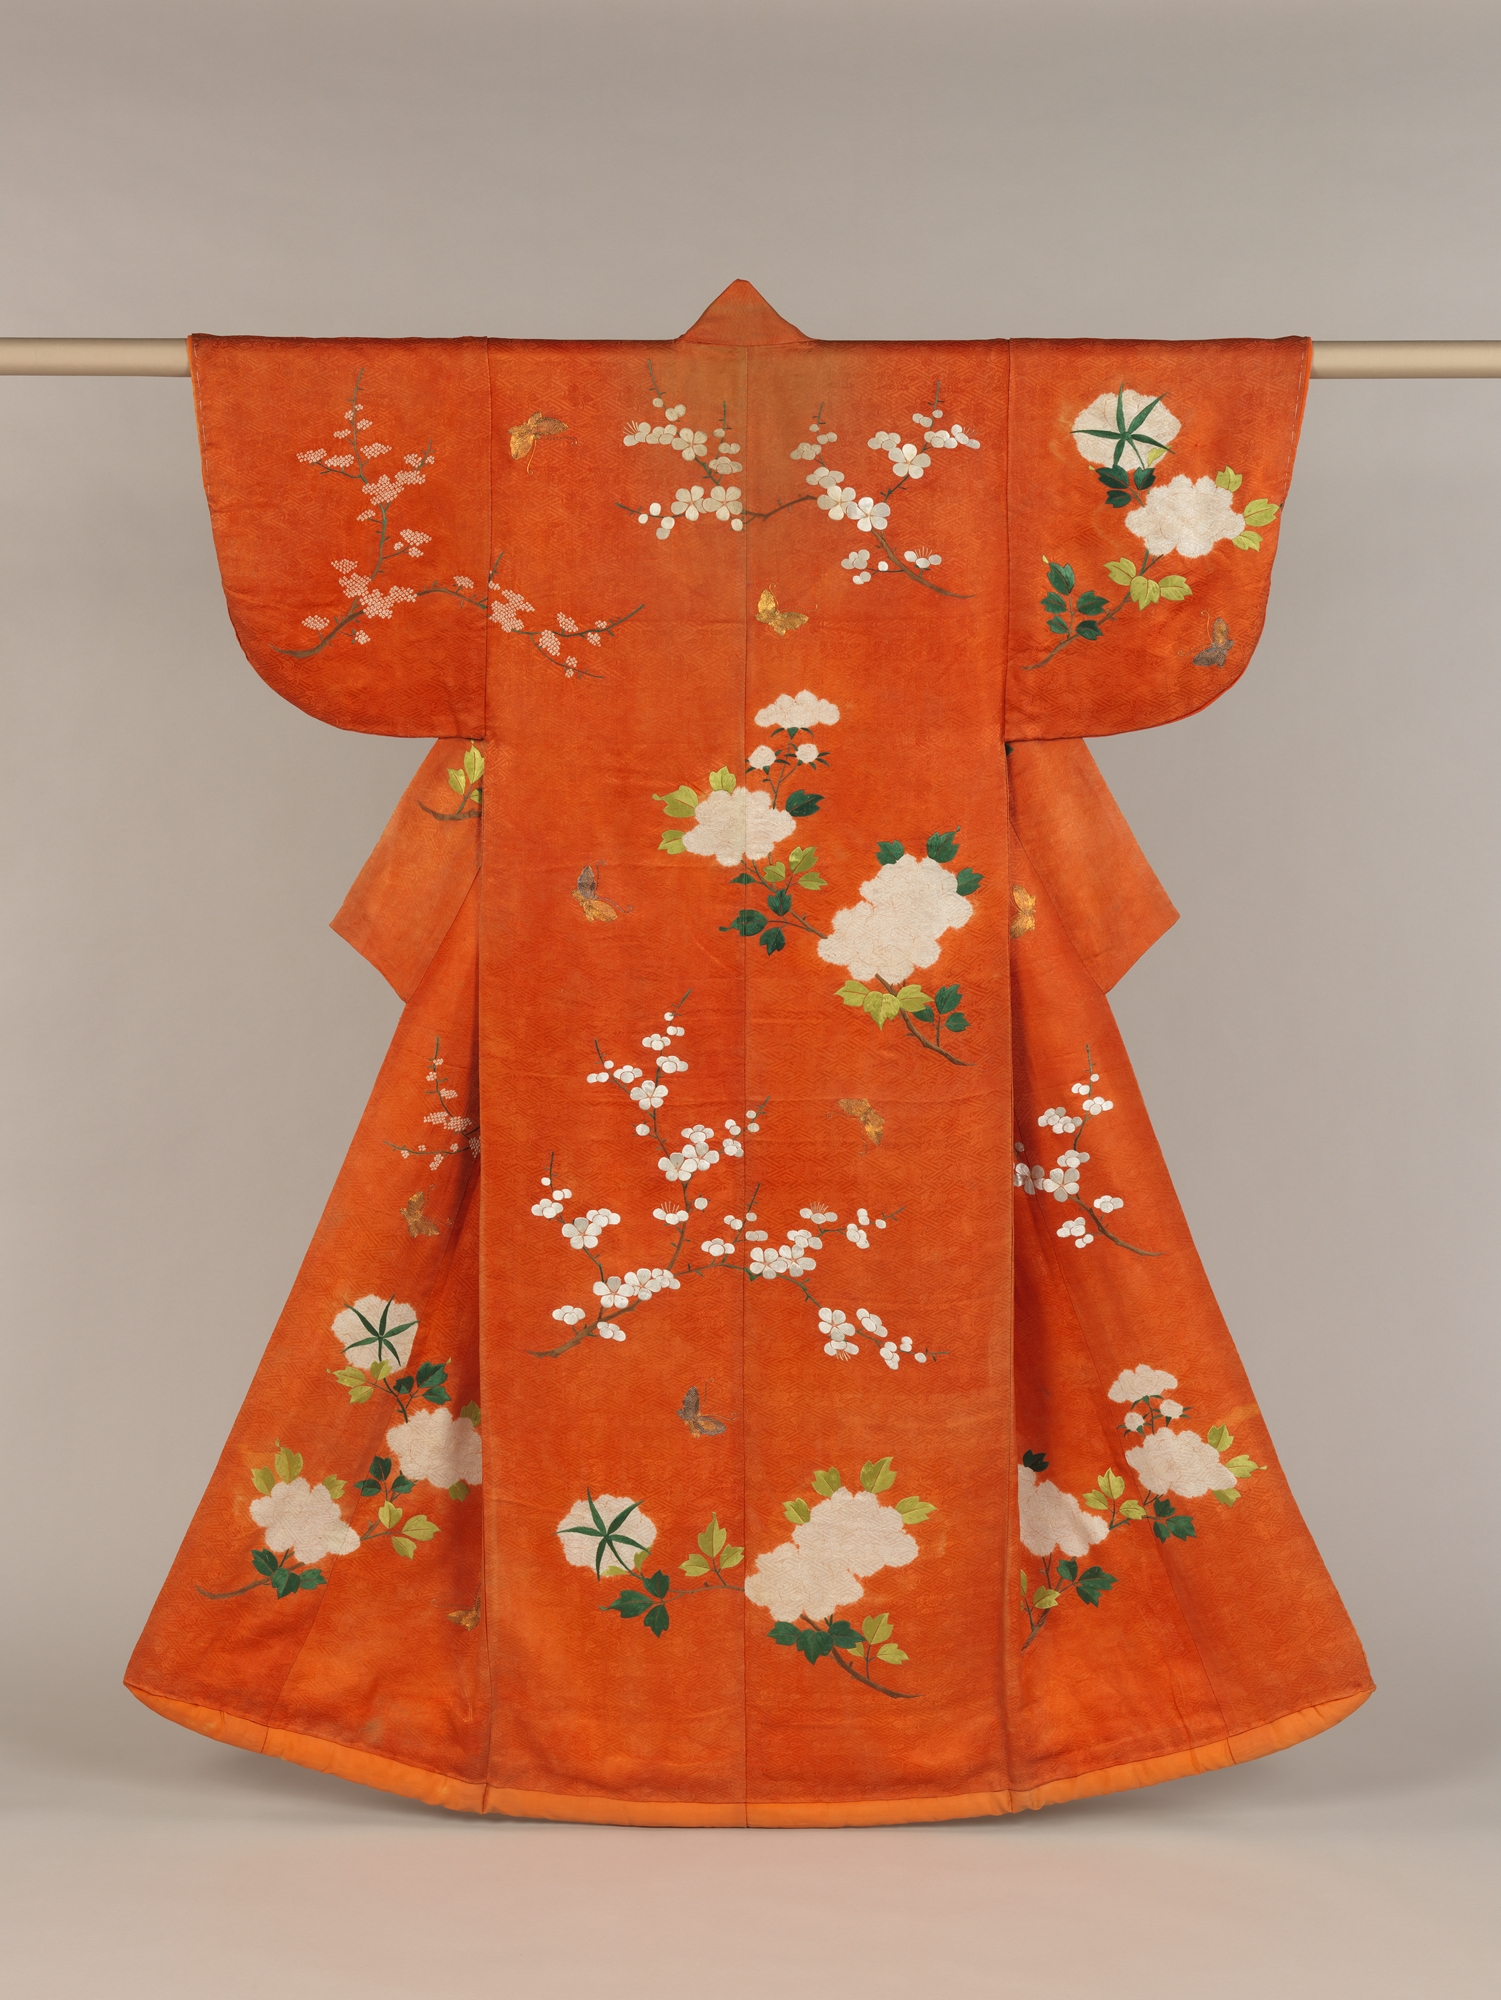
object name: robe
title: Outer Robe (Uchikake) with Peonies, Plum Blossoms, and Butterflies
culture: japanese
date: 1767-1833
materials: metal thread, silk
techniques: damask, embroidery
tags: butterflies,peonies